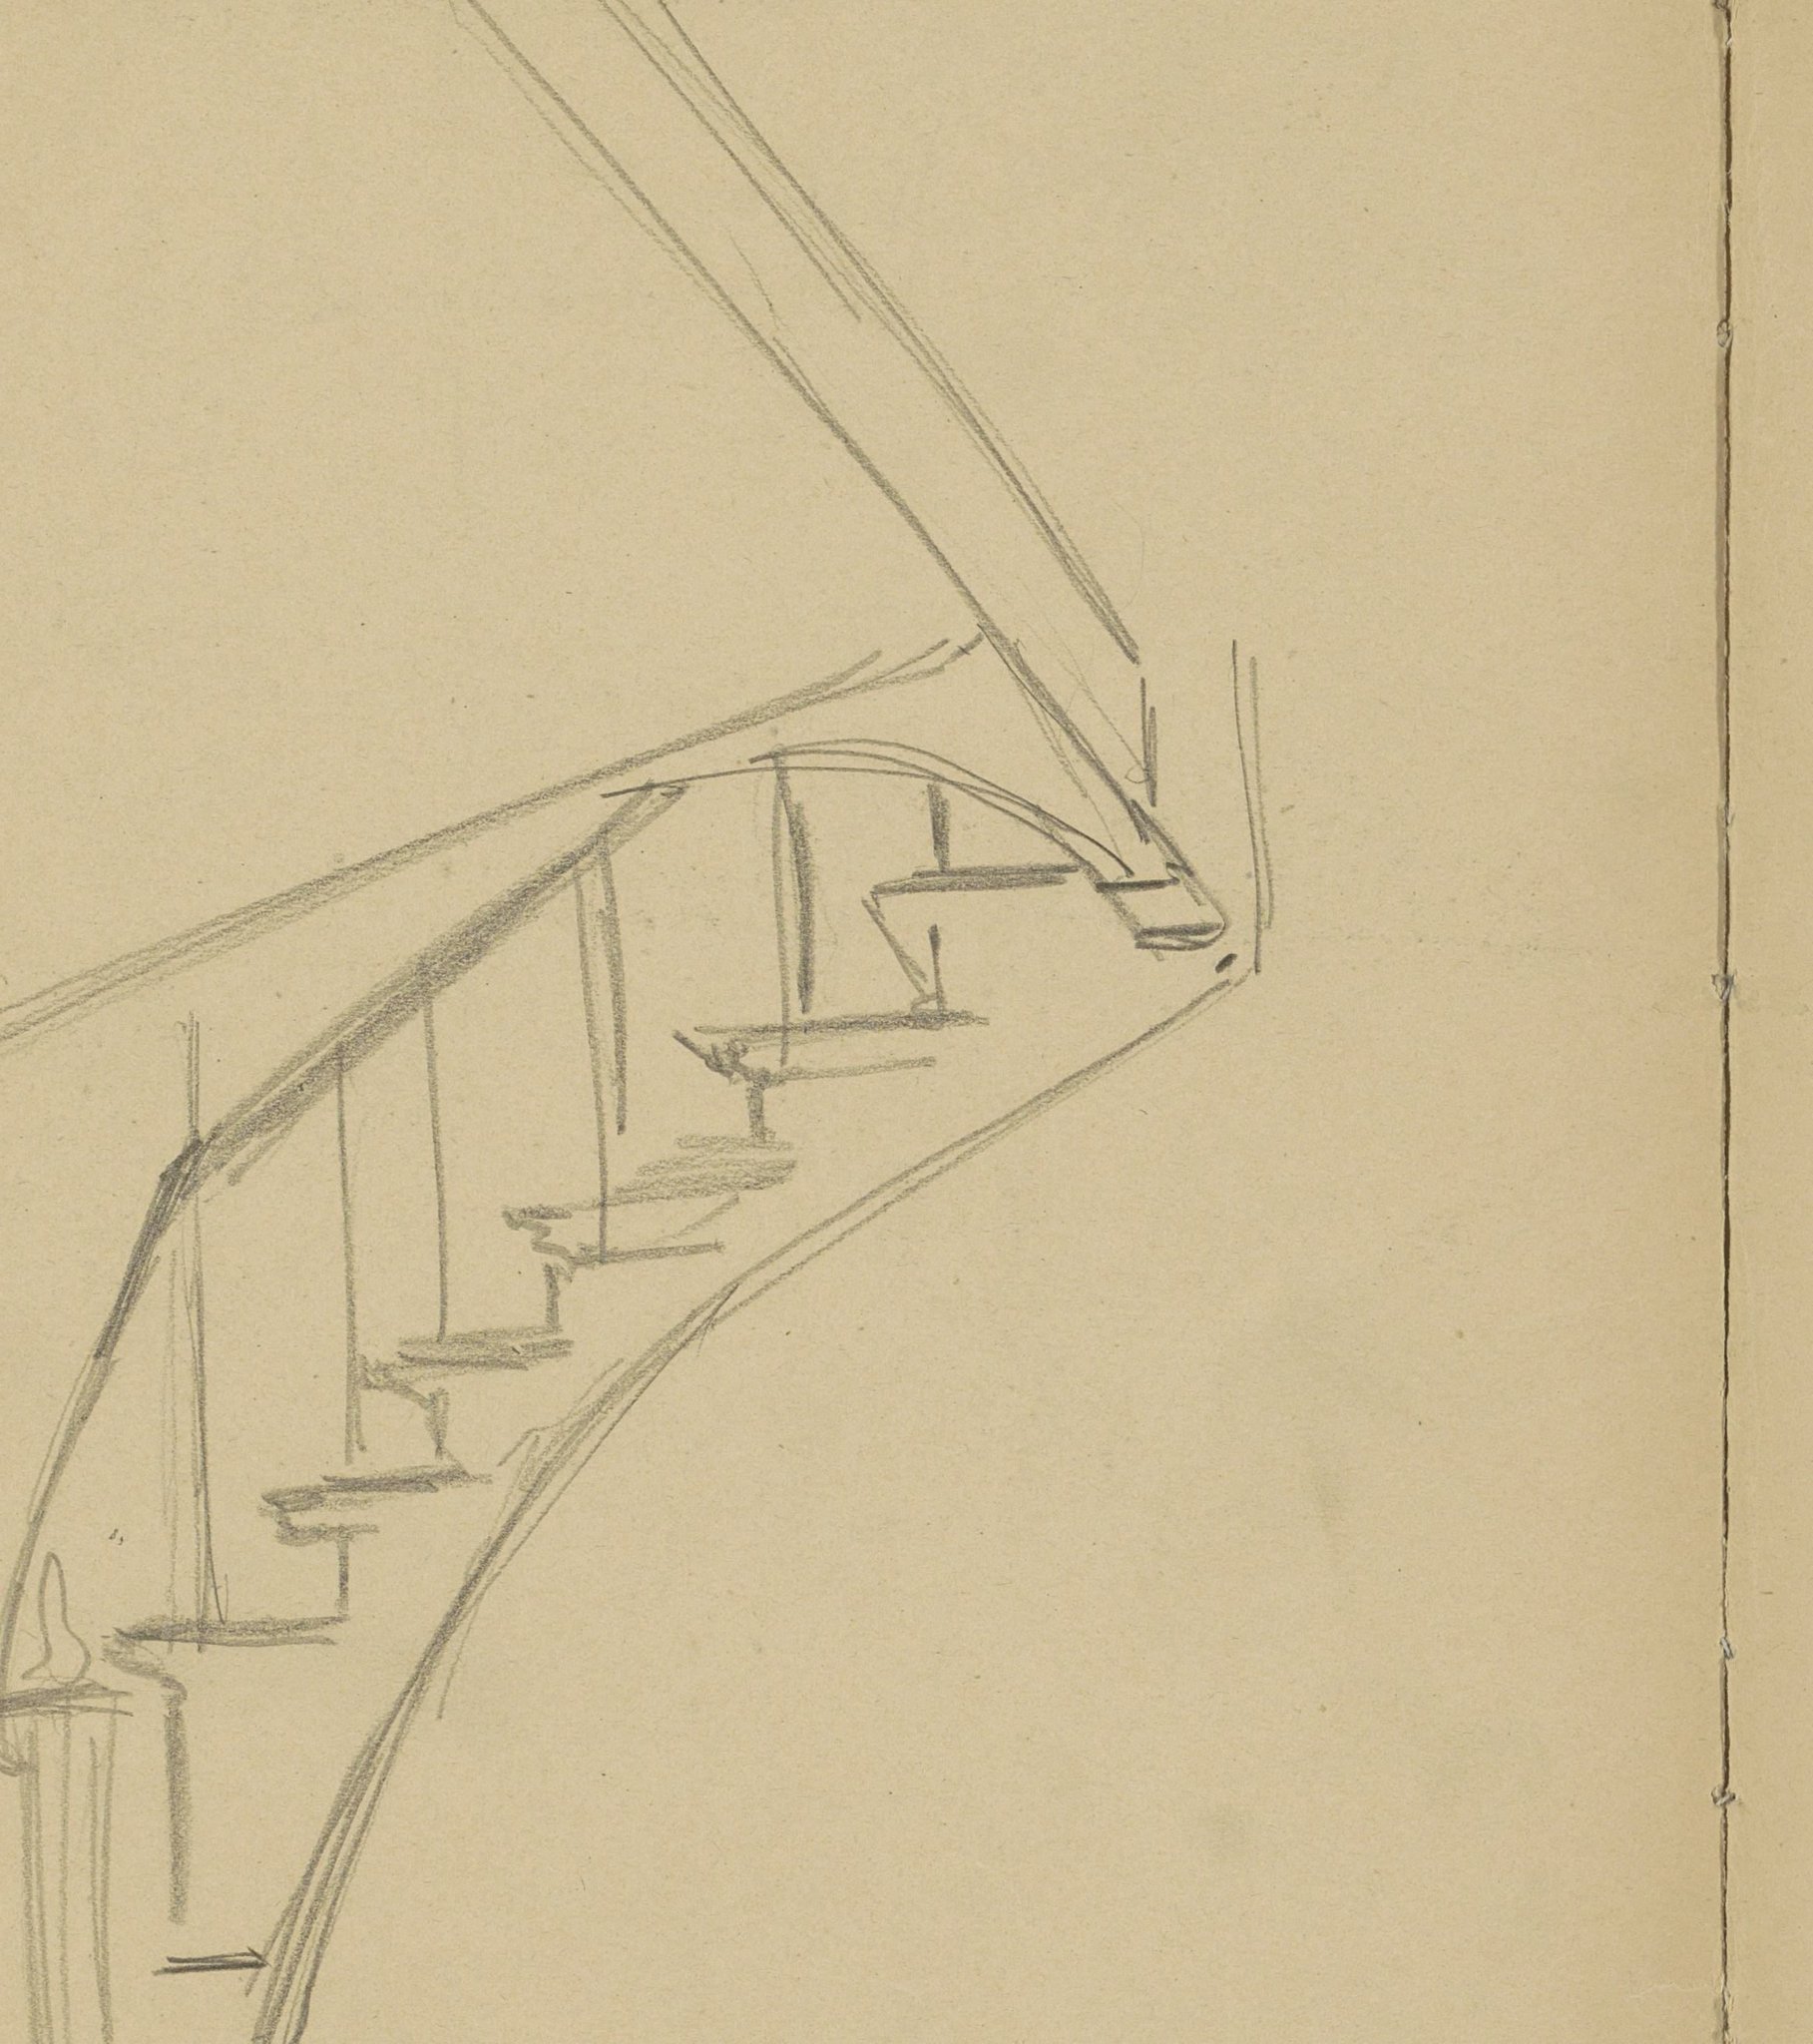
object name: sketchbook leaf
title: Ontwerp voor een trap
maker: carel adolph lion cachet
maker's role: draughtsman, print maker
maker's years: 1864-1945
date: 1906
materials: paper, pencil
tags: staircase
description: Blad 2 verso uit een schetsboek met 27 bladen.